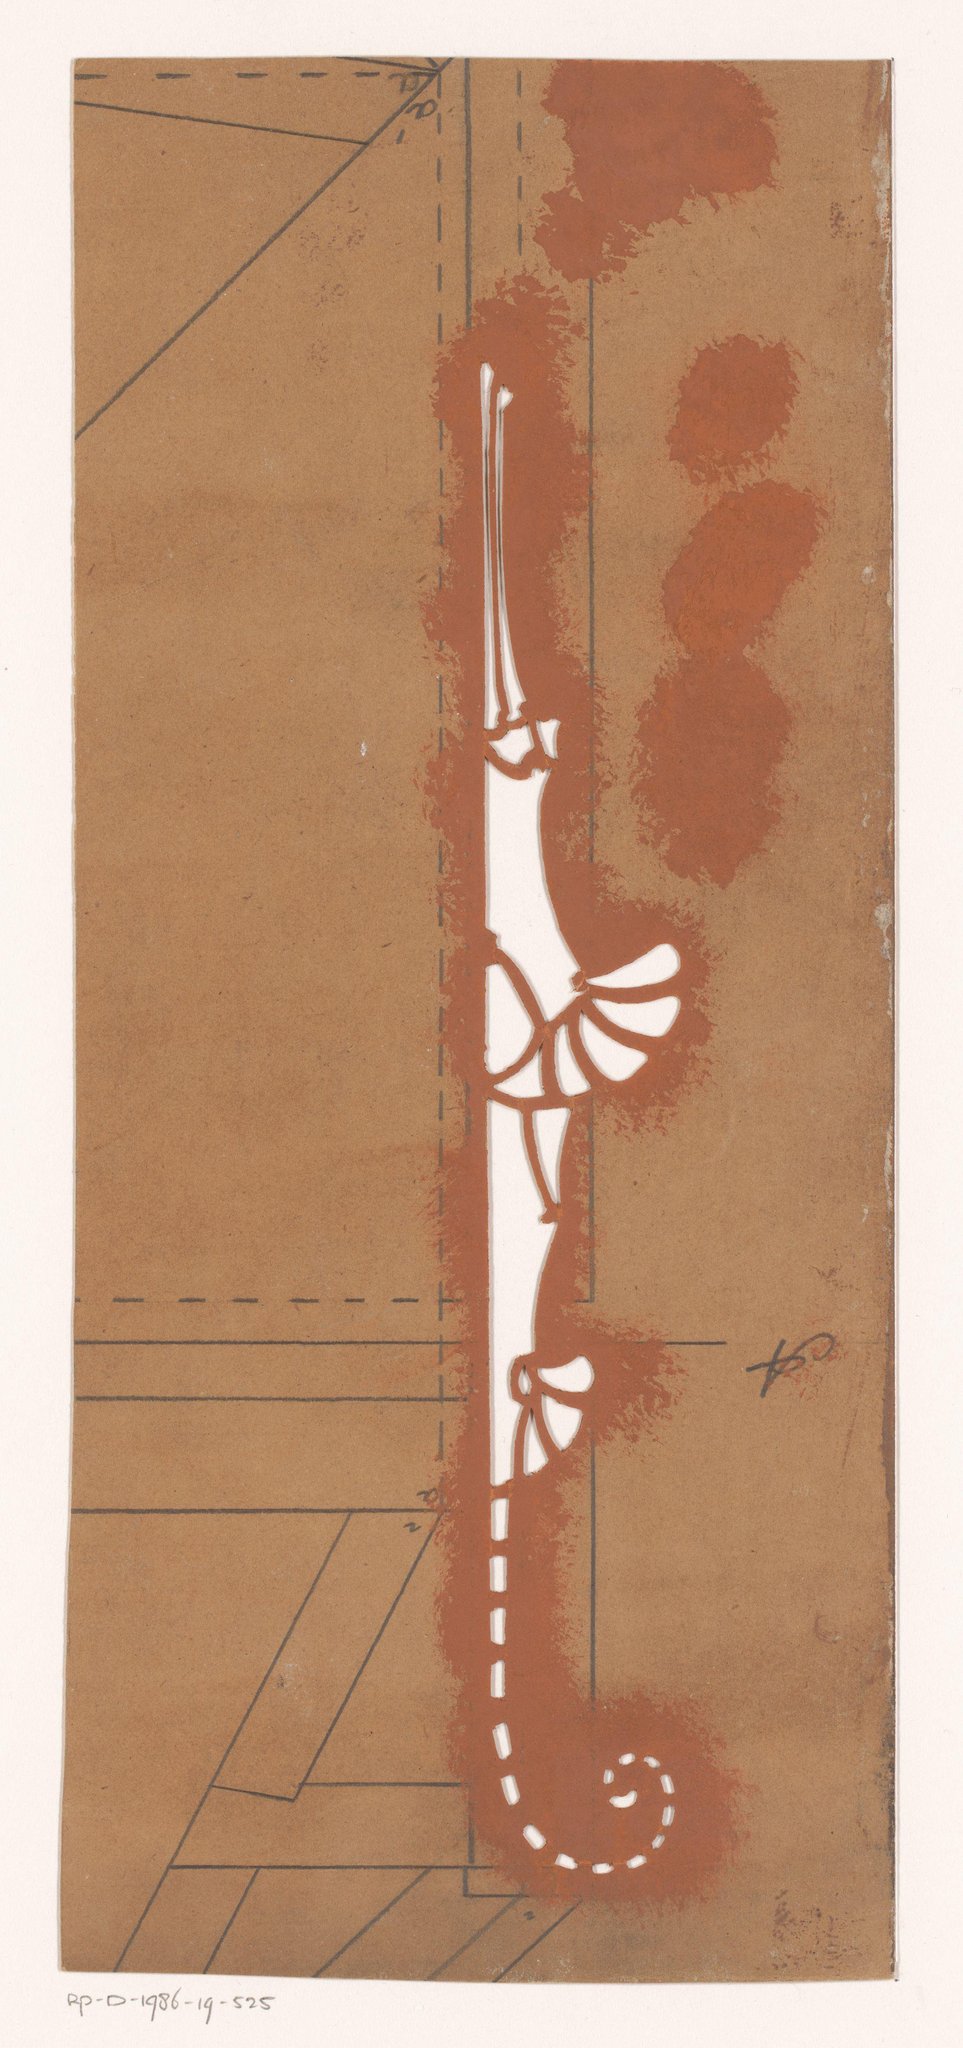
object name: template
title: Sjabloon met ornament, mogelijk een liggend dier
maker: reinier willem petrus de vries (1874-1953)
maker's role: draughtsman, print maker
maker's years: 1874-1953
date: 1884-1952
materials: paper, pencil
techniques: cutting, snipping